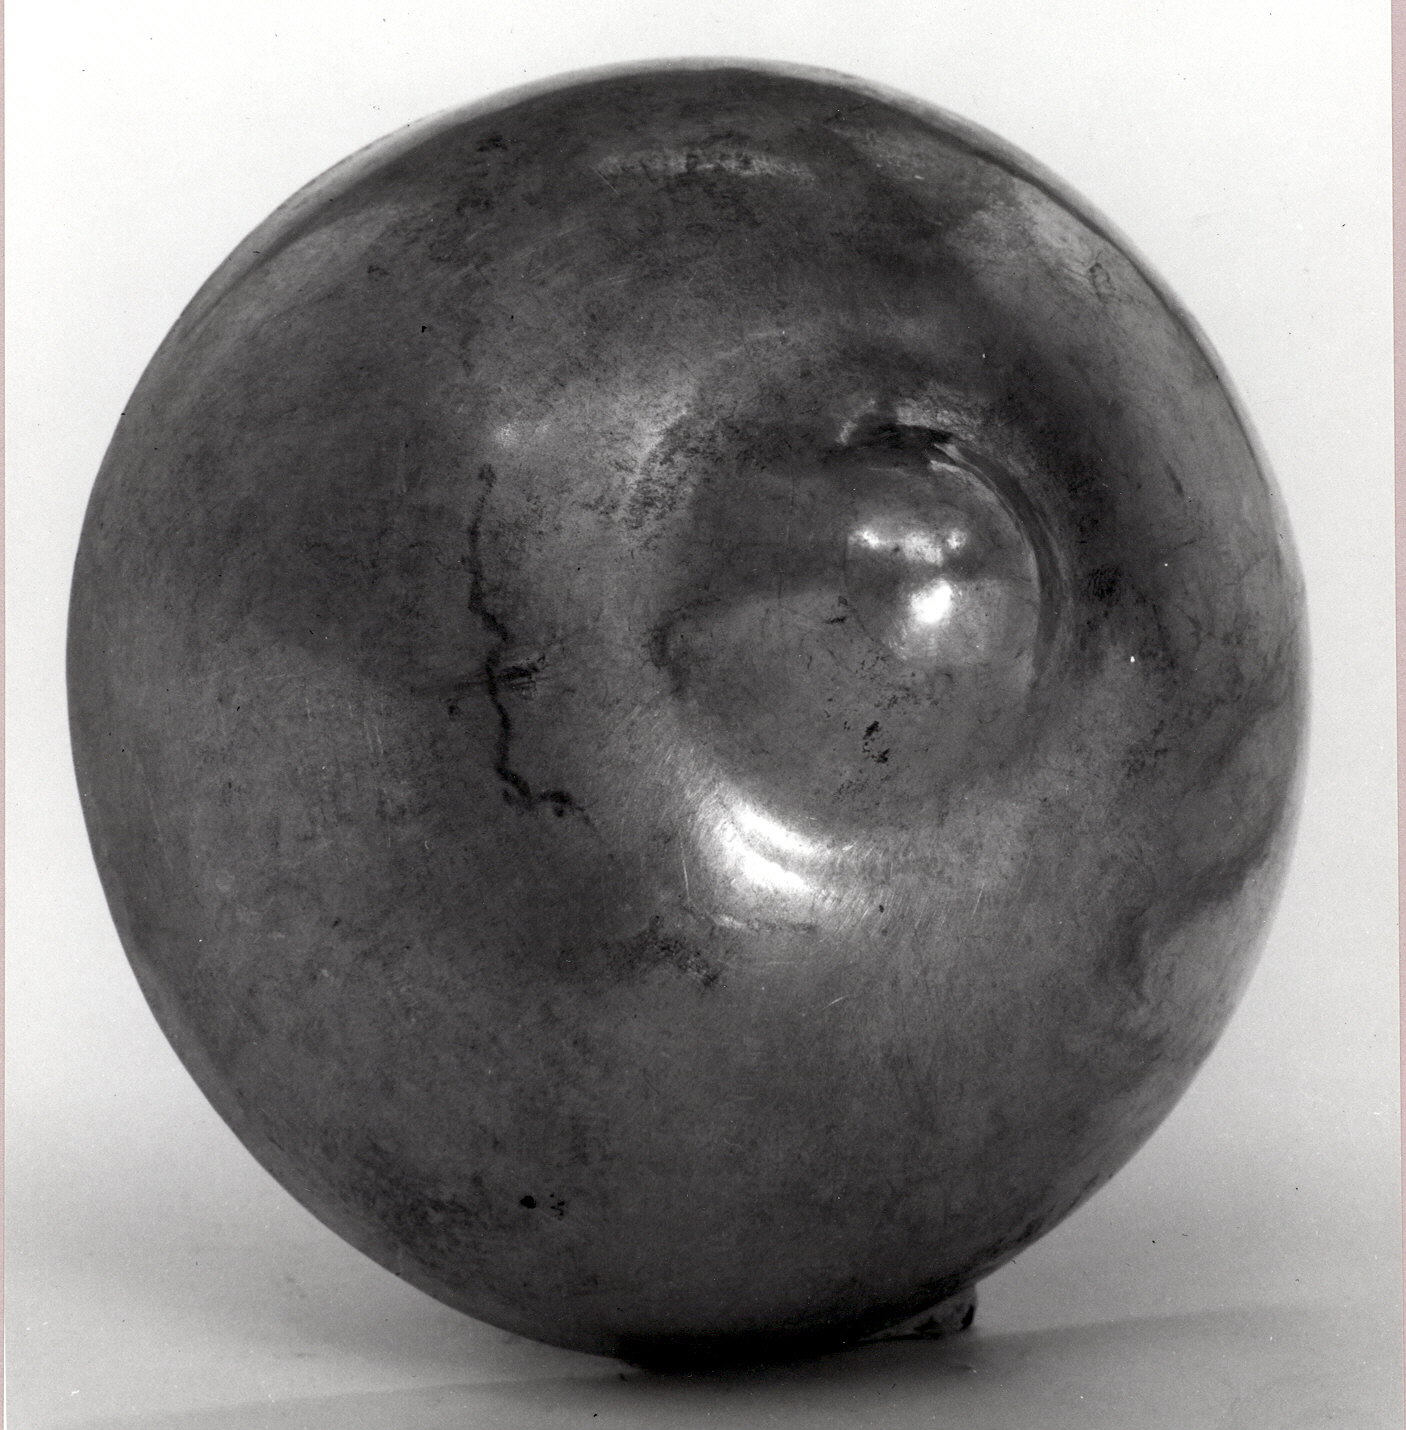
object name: bowl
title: Bowl (?)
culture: colombian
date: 901-1600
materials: gold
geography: colombia